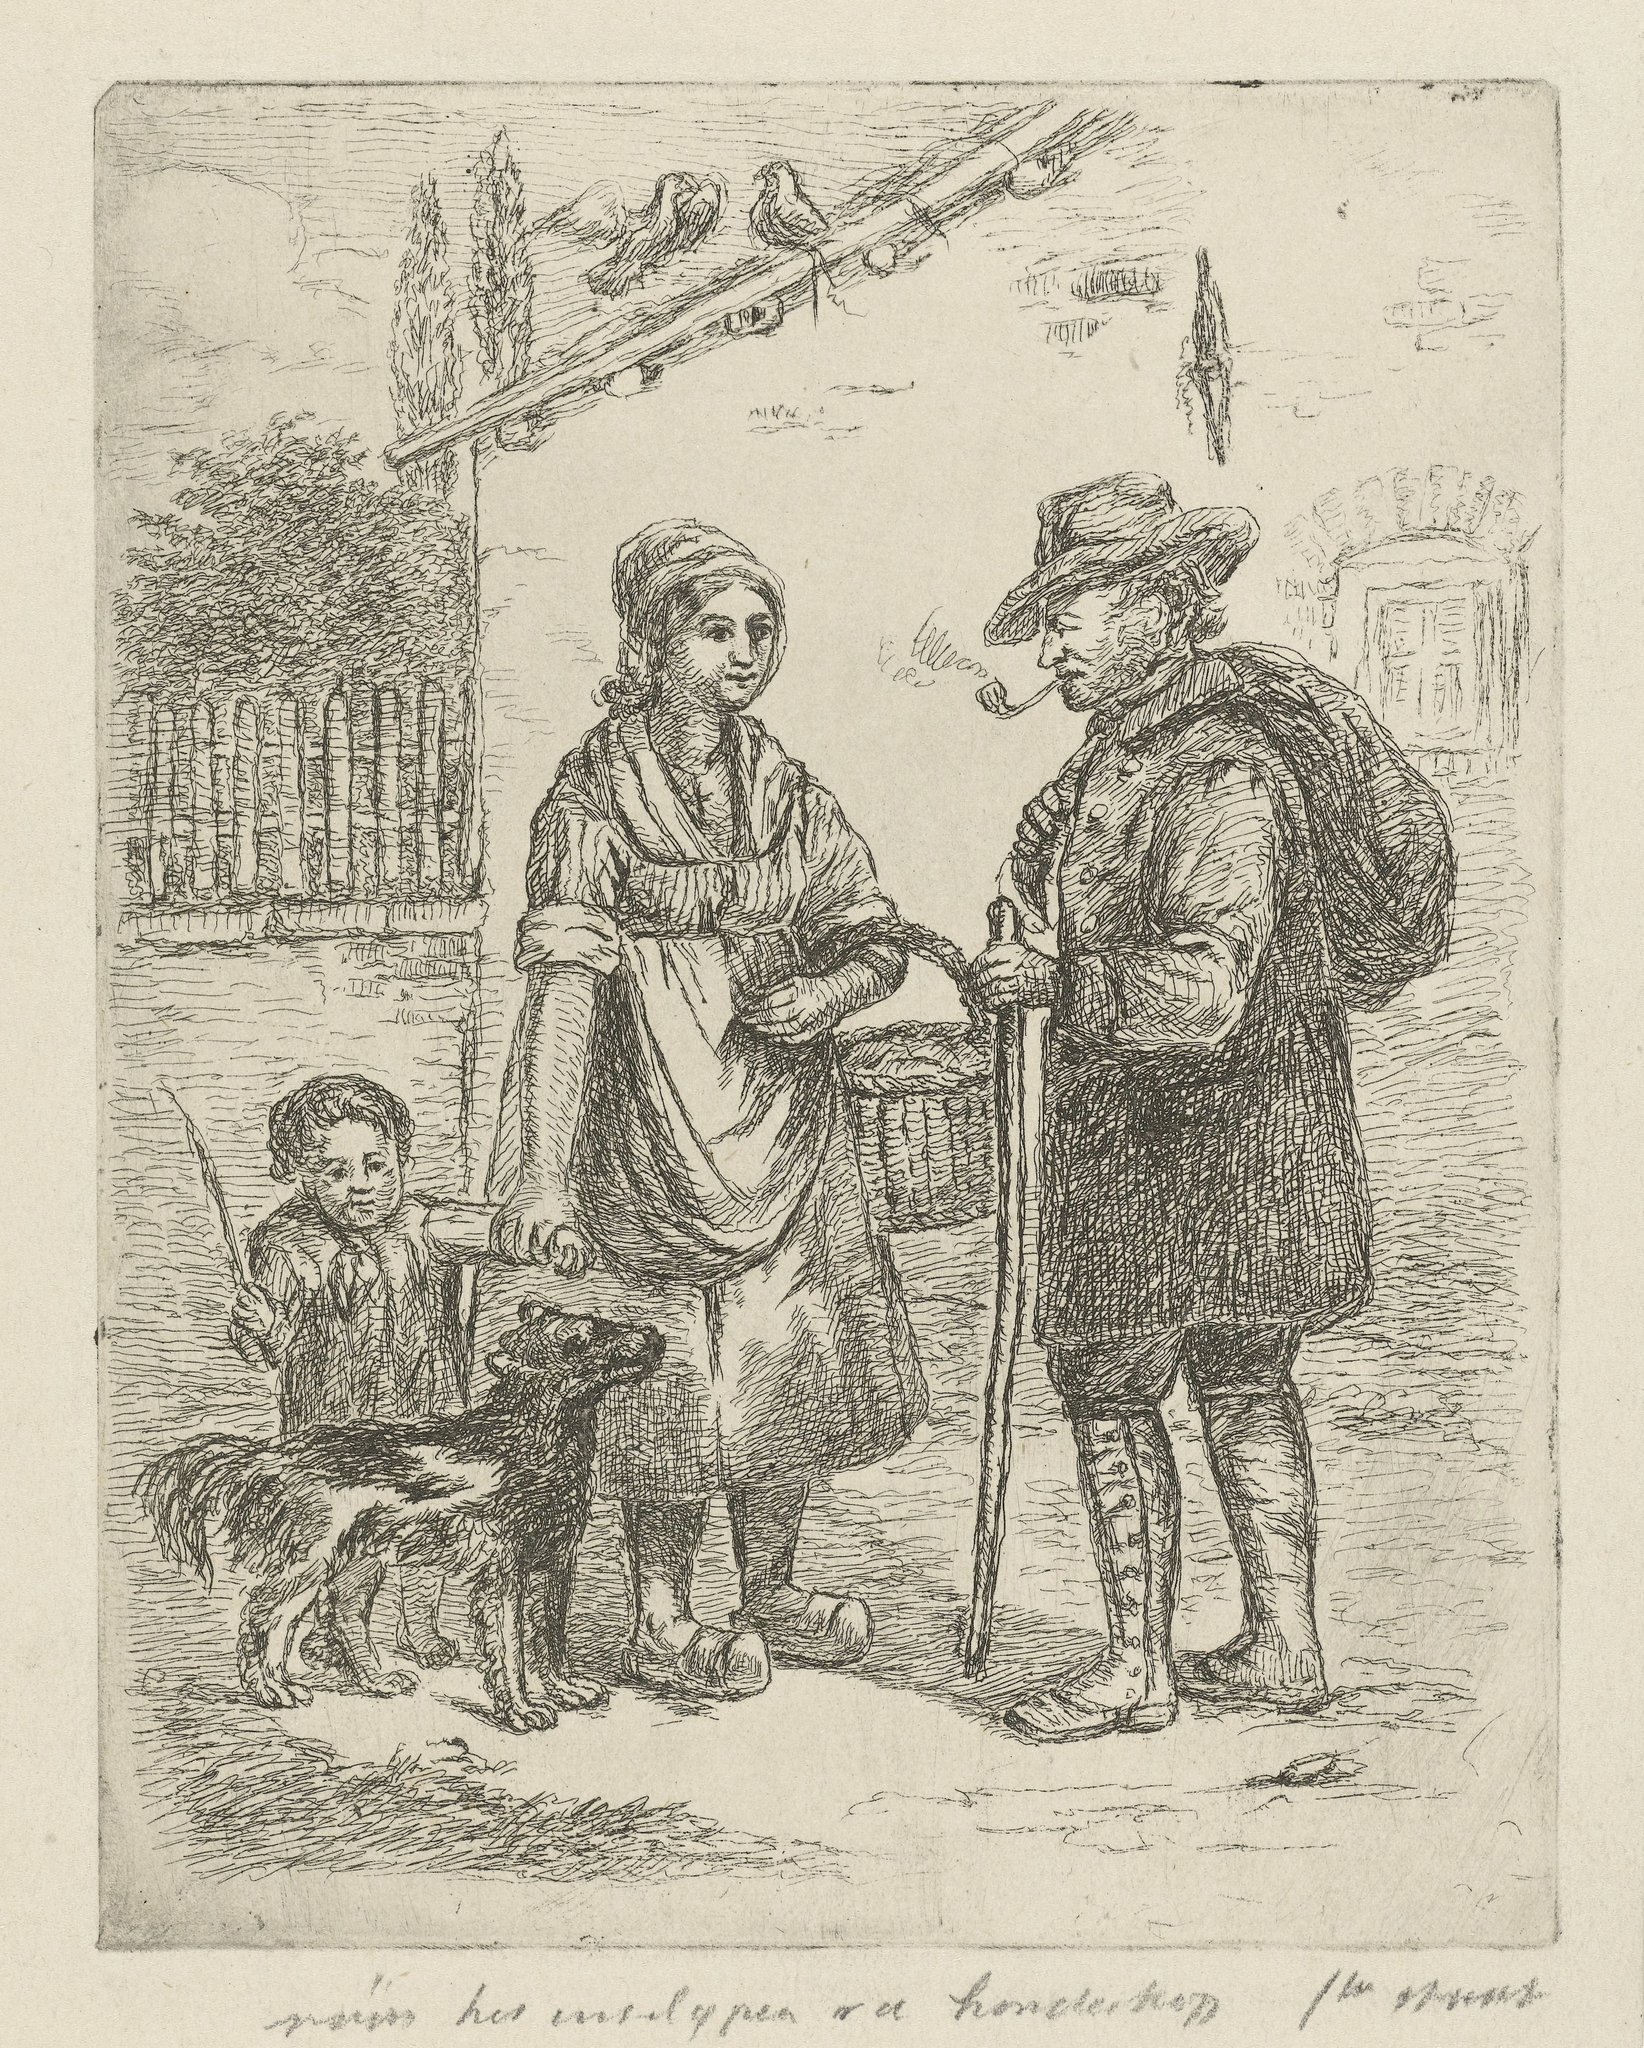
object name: print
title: Boer en boerin bij hoeve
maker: david van der kellen (1804-1879)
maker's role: die cutter, draughtsman, print maker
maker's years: 1804-1879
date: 1814-1879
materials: paper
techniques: etching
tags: pipe ~ tobacco, farmers - aa - female farmer, farmer's wife, dog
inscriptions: inscription: ‘voor het ..slijpen vd hondenkop 1de staat’, collector's mark: Lugt 2228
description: Voor een huis staan een pijprokende man met een wandelstok en hoed en een boerin met een kind aan haar hand. De boerin draagt een mand. Naast hen een hondje en op het dak van het huis zitten twee tortelduiven.